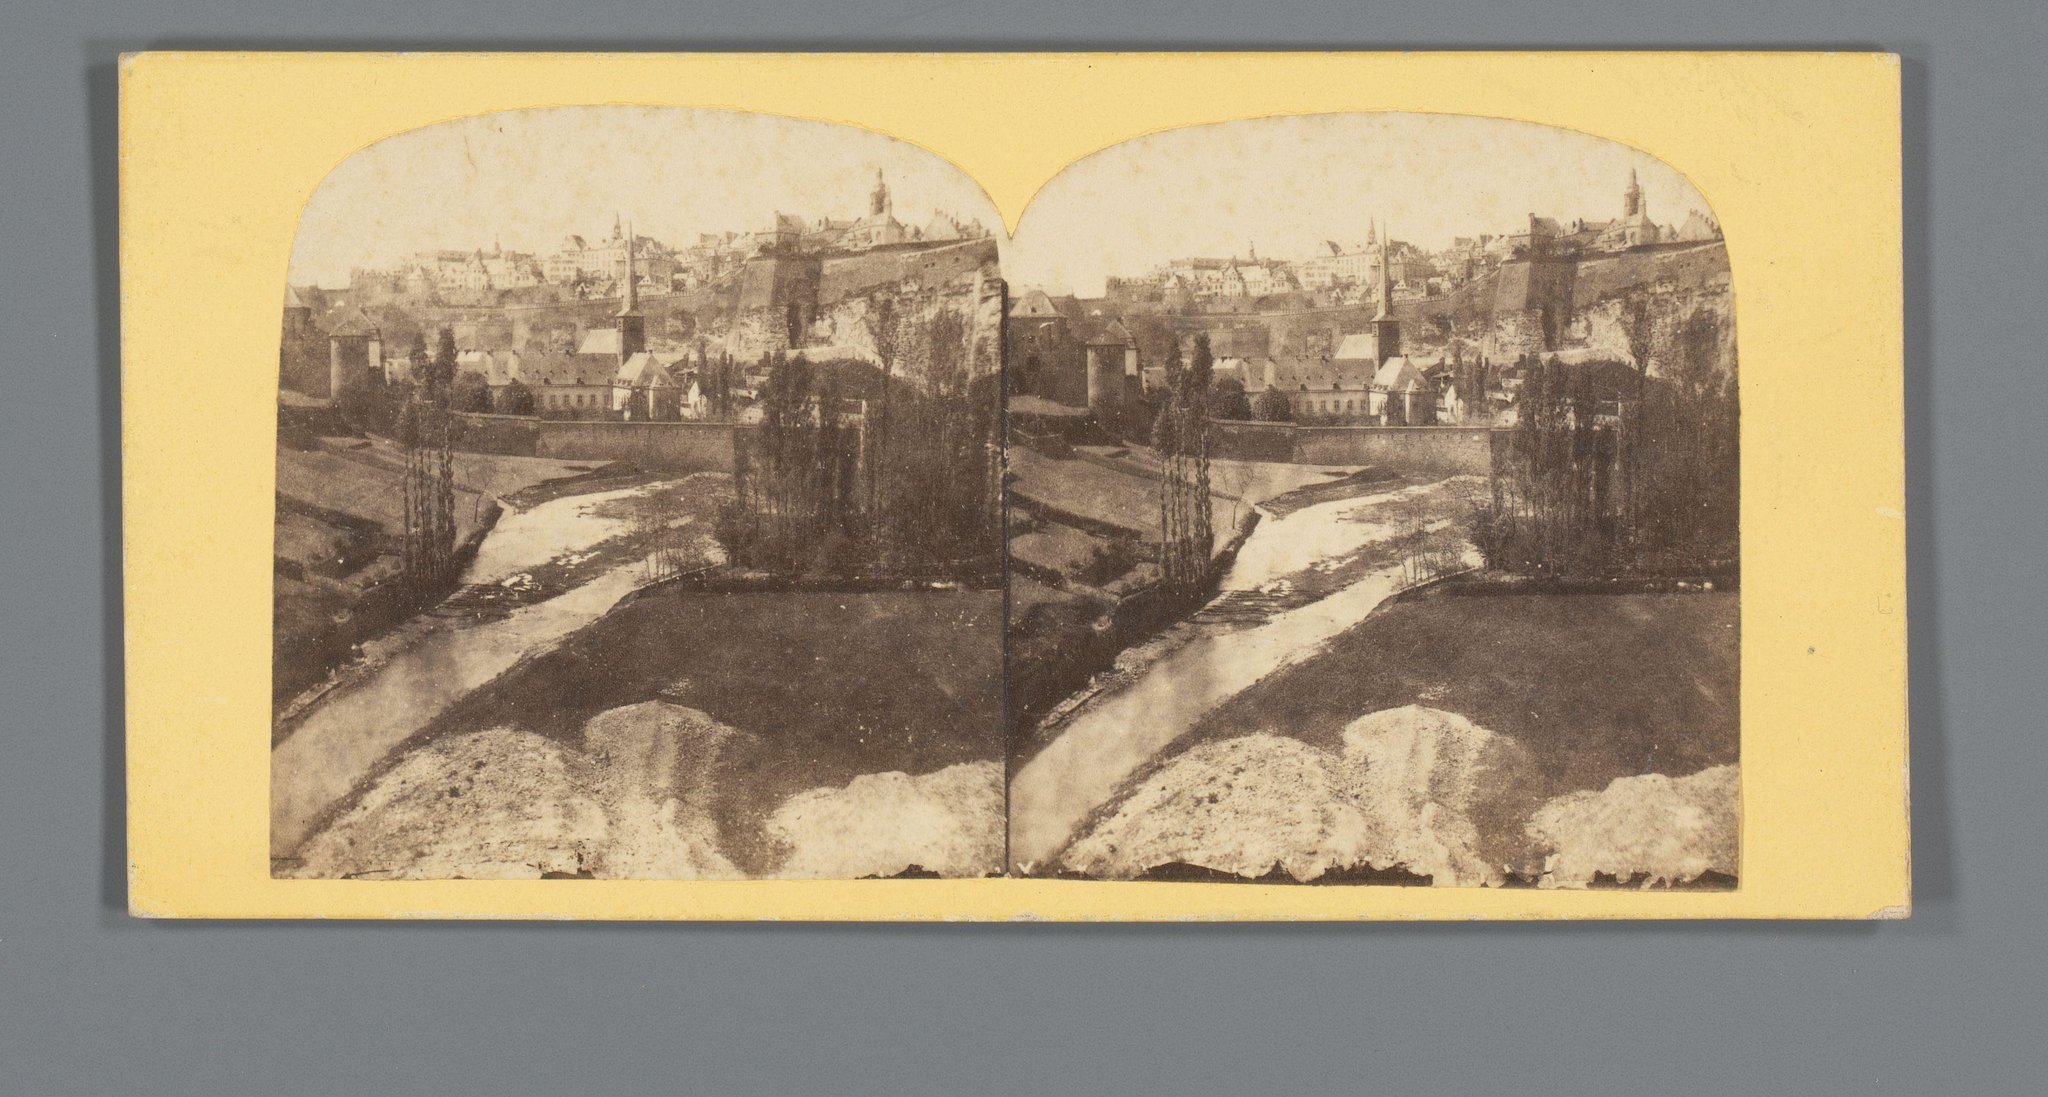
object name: stereograph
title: Gezicht op Luxemburg gezien vanaf het spoorviaduct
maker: Anonymous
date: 1861-1870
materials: cardboard, paper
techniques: albumen print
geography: luxembourg city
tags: city-view, and landscape with man-made constructions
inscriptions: number: ‘No. 2.’, collector's mark: ‘Librairie de E. HOFFMAN à Luxembourg.’